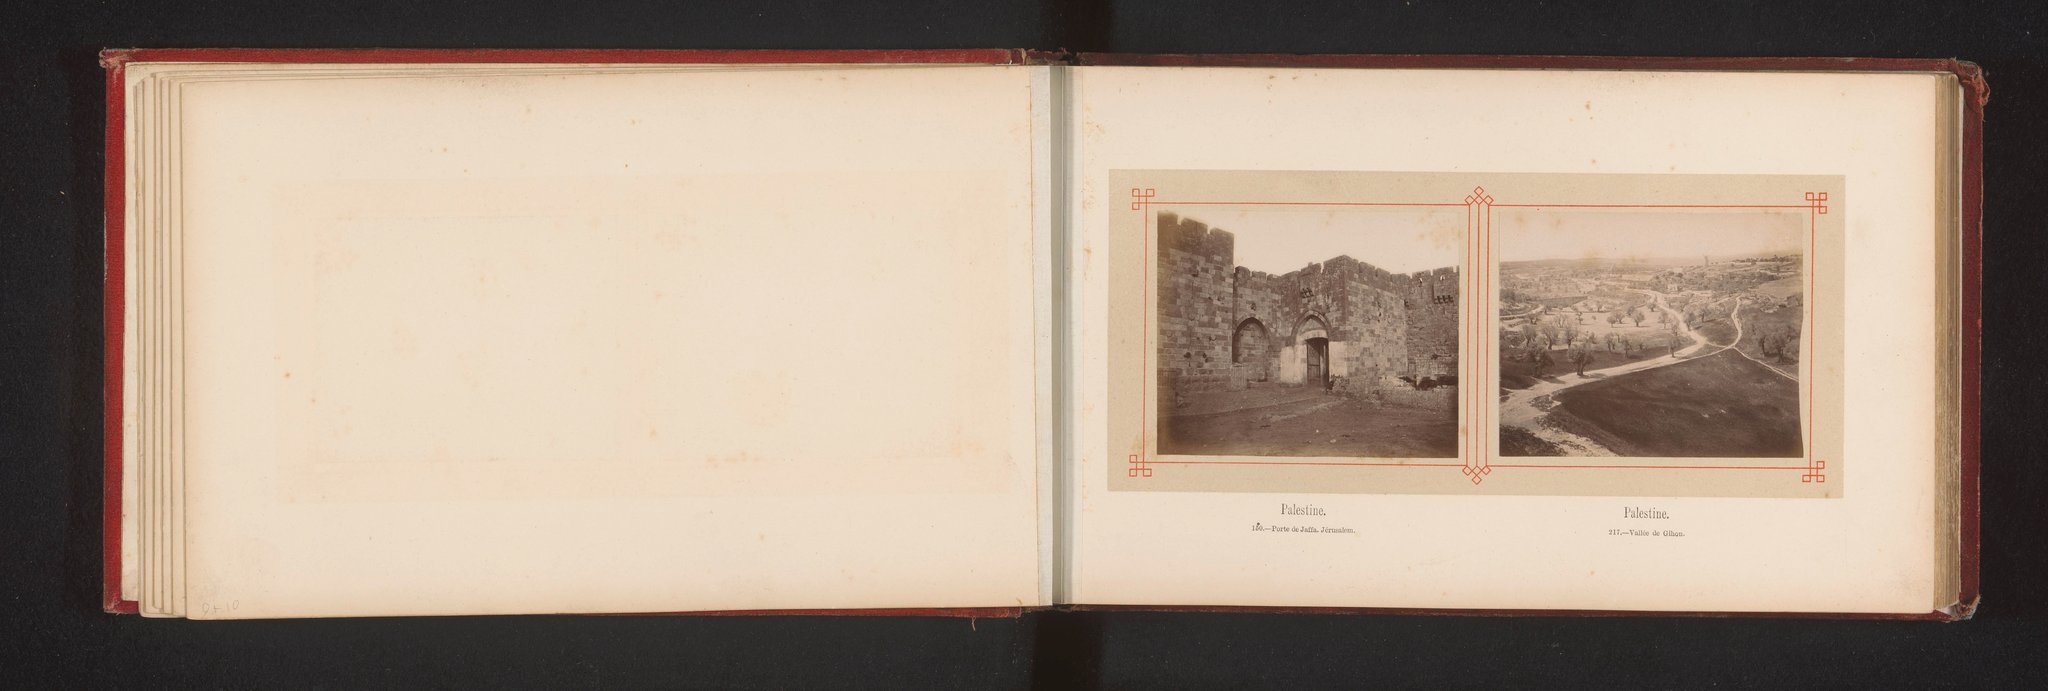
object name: photograph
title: Palestine - 150 - Porte de Jaffa, Jérusalem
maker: félix bonfils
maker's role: fotograaf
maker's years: 1831-1885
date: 1873-1878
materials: photographic support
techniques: albumen print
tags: gate, entrance